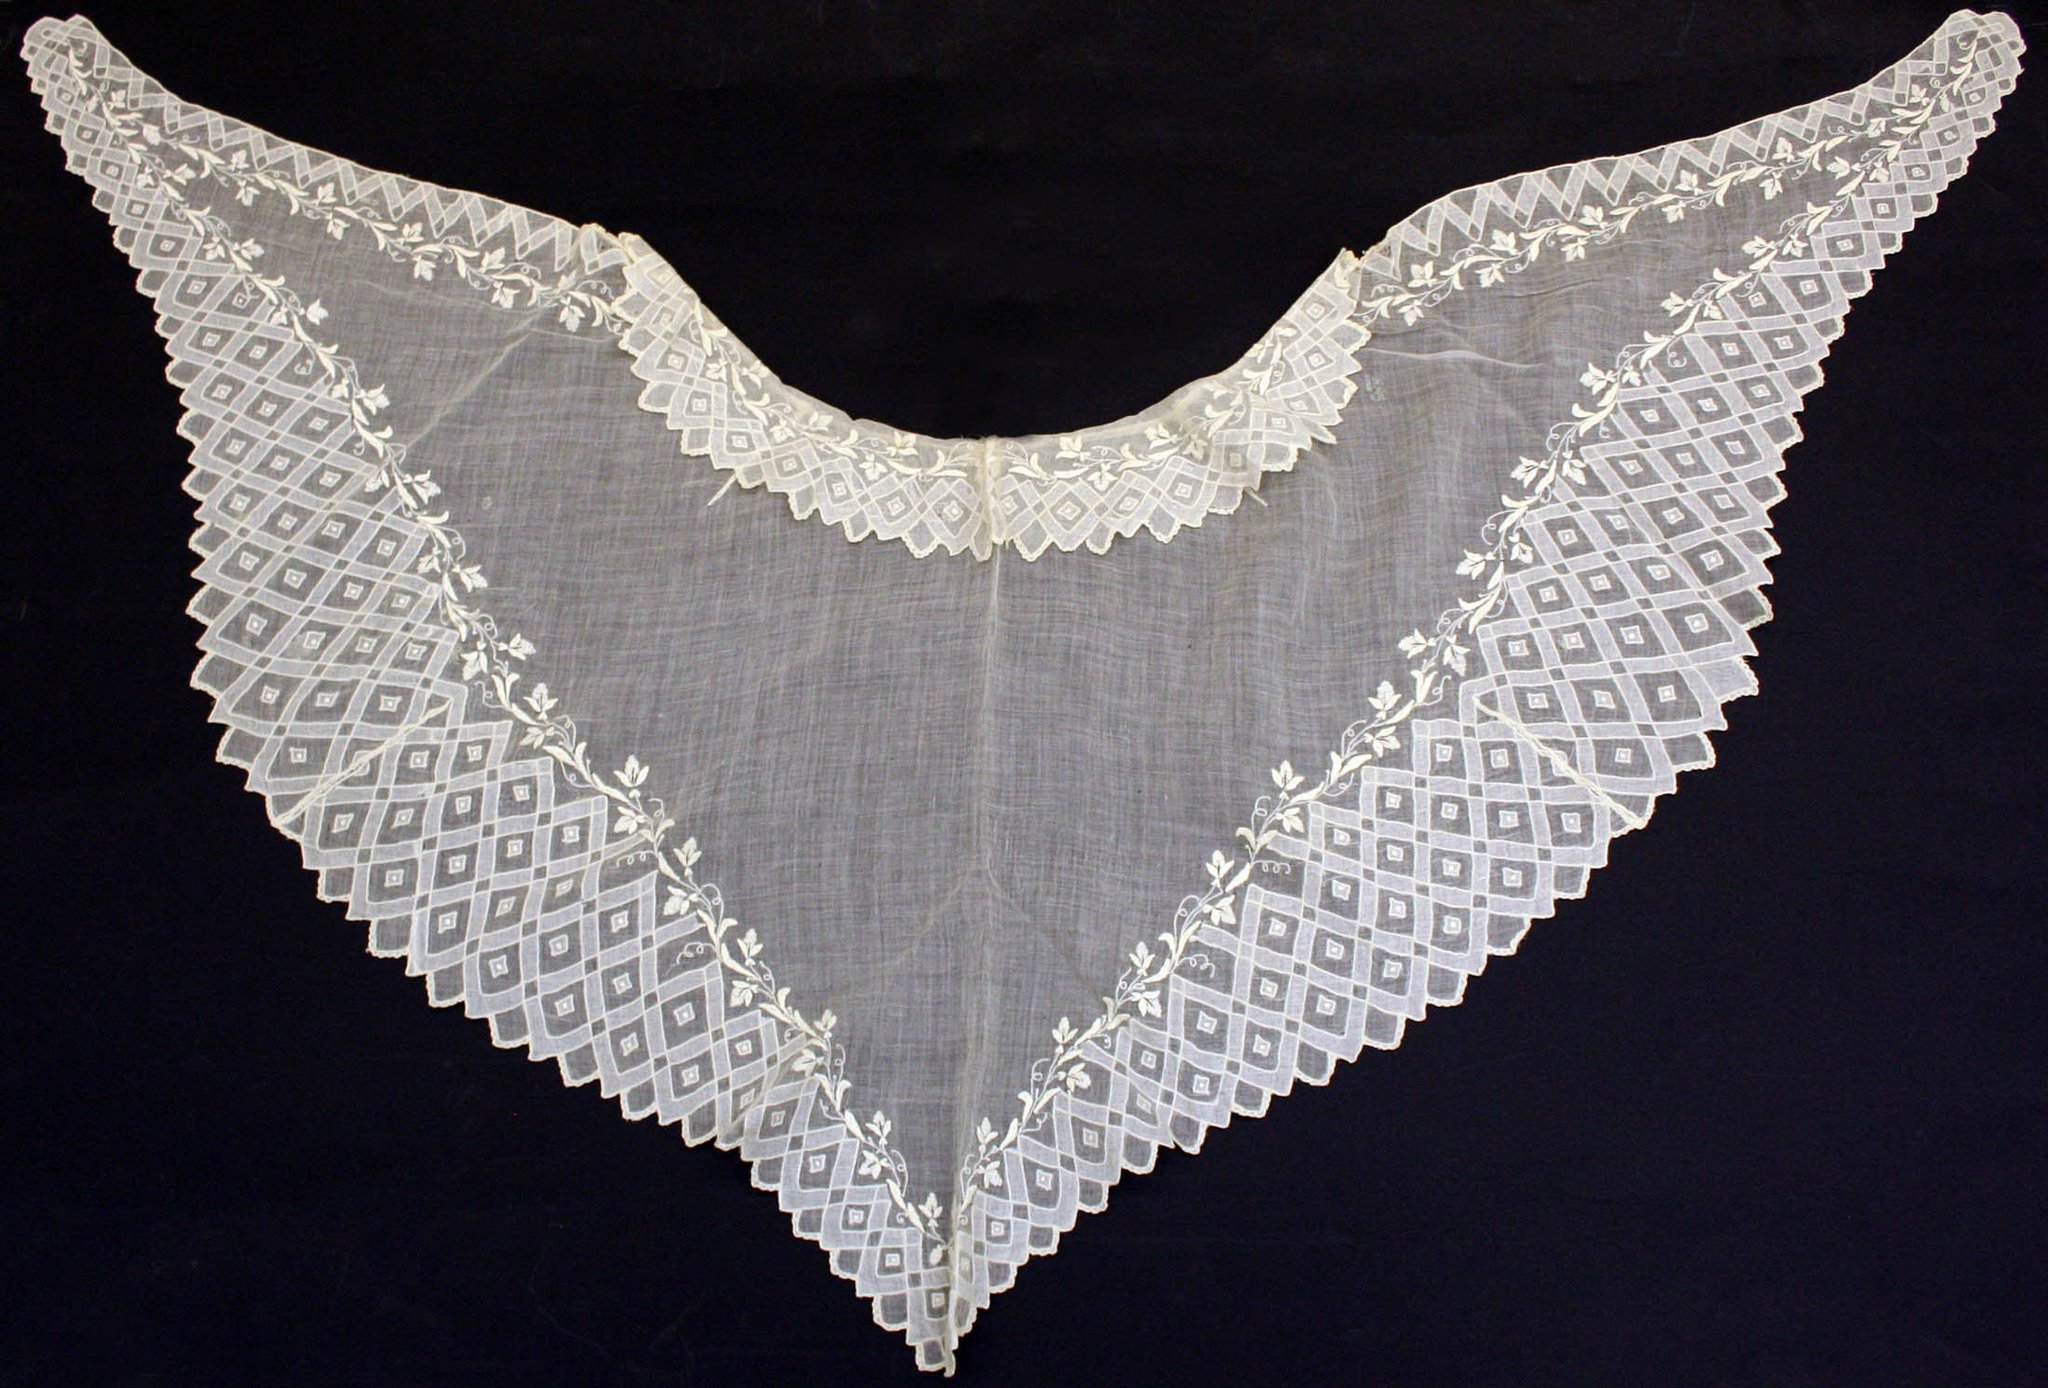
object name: pelerine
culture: french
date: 1830-1835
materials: cotton